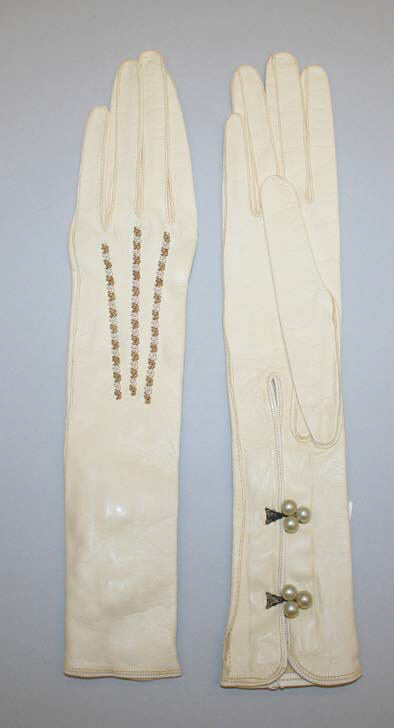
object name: glove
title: Gloves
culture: french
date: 1878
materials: leather, silk